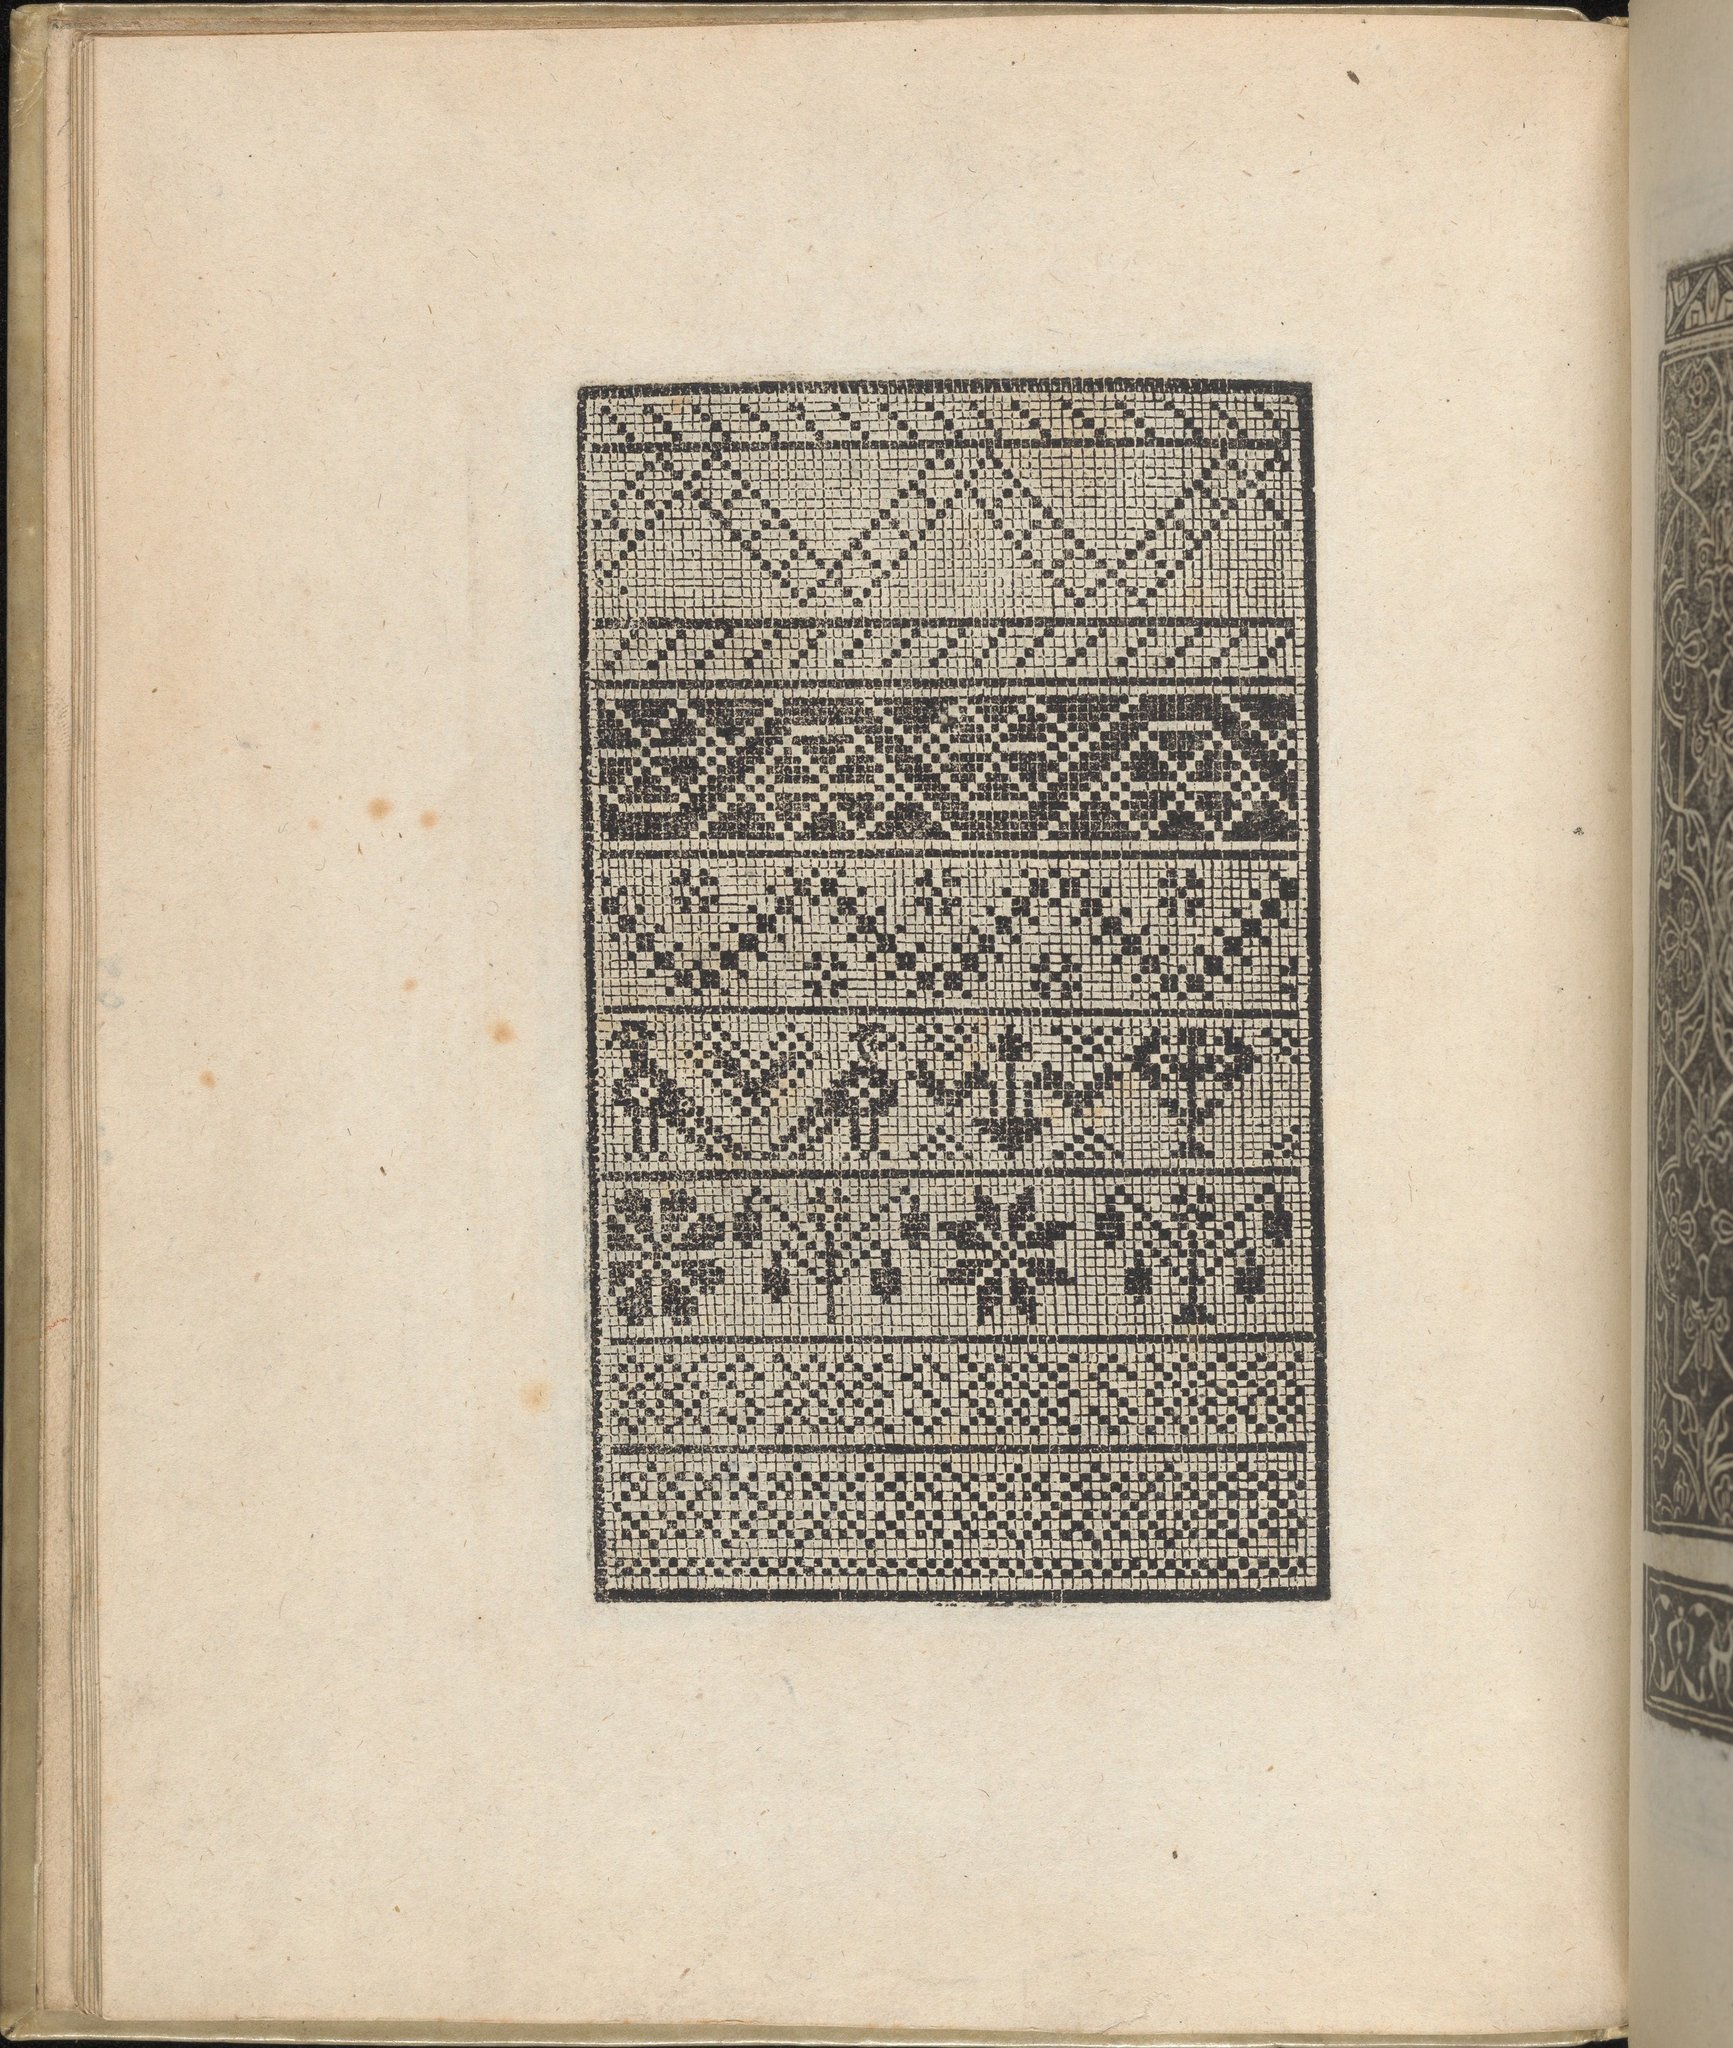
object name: book print ornament architecture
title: Trionfo Di Virtu. Libro Novo..., page 7 (verso)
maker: matteo pagano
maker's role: publisher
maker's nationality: italian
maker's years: 1515-1588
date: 1563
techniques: woodcut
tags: ornament